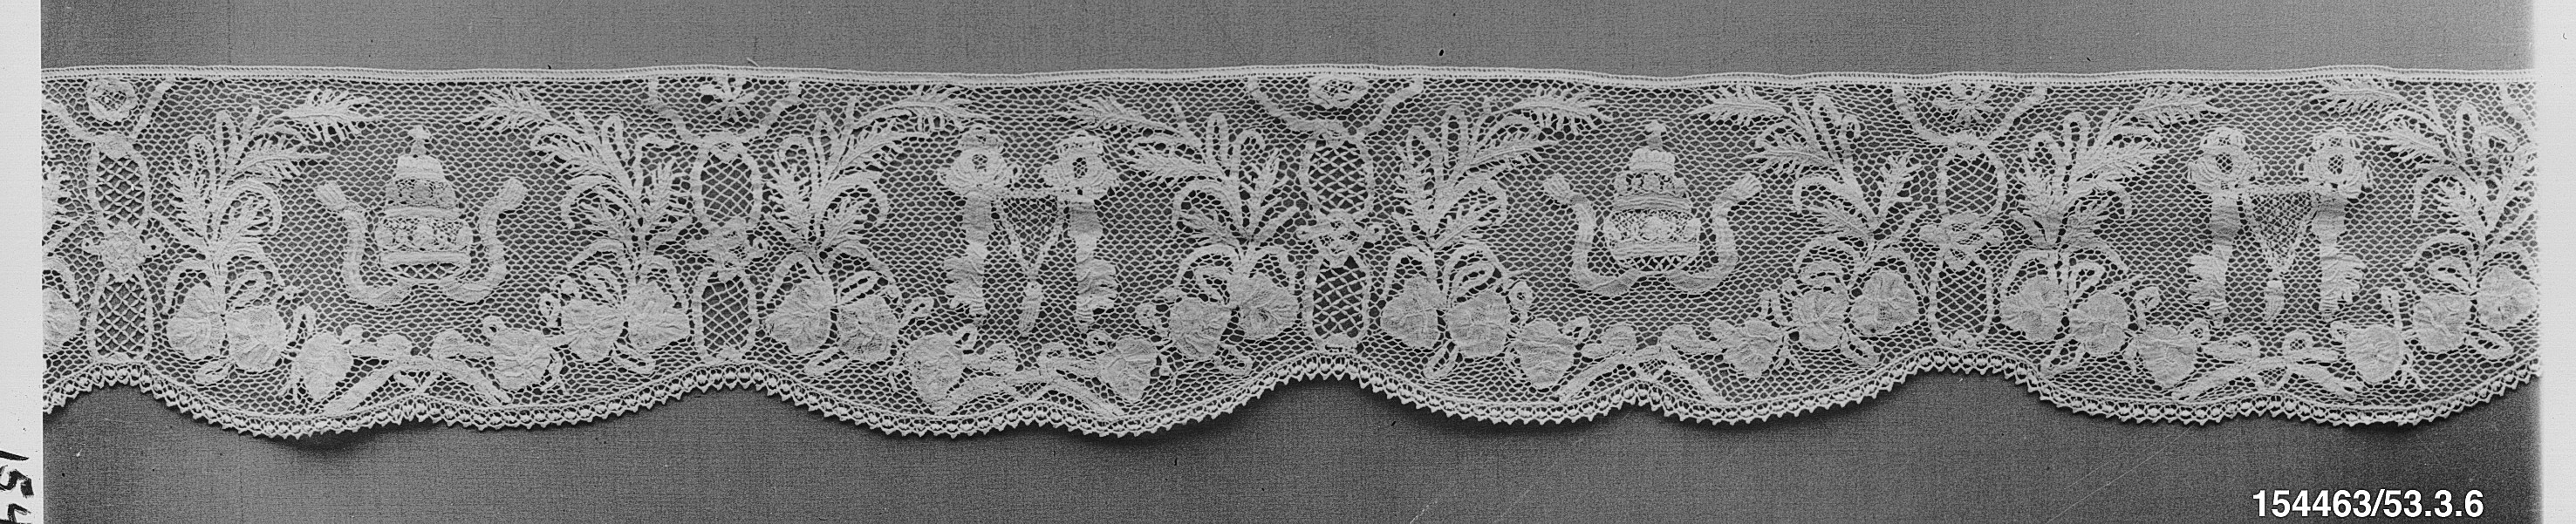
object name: border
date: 1701-1800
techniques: lace